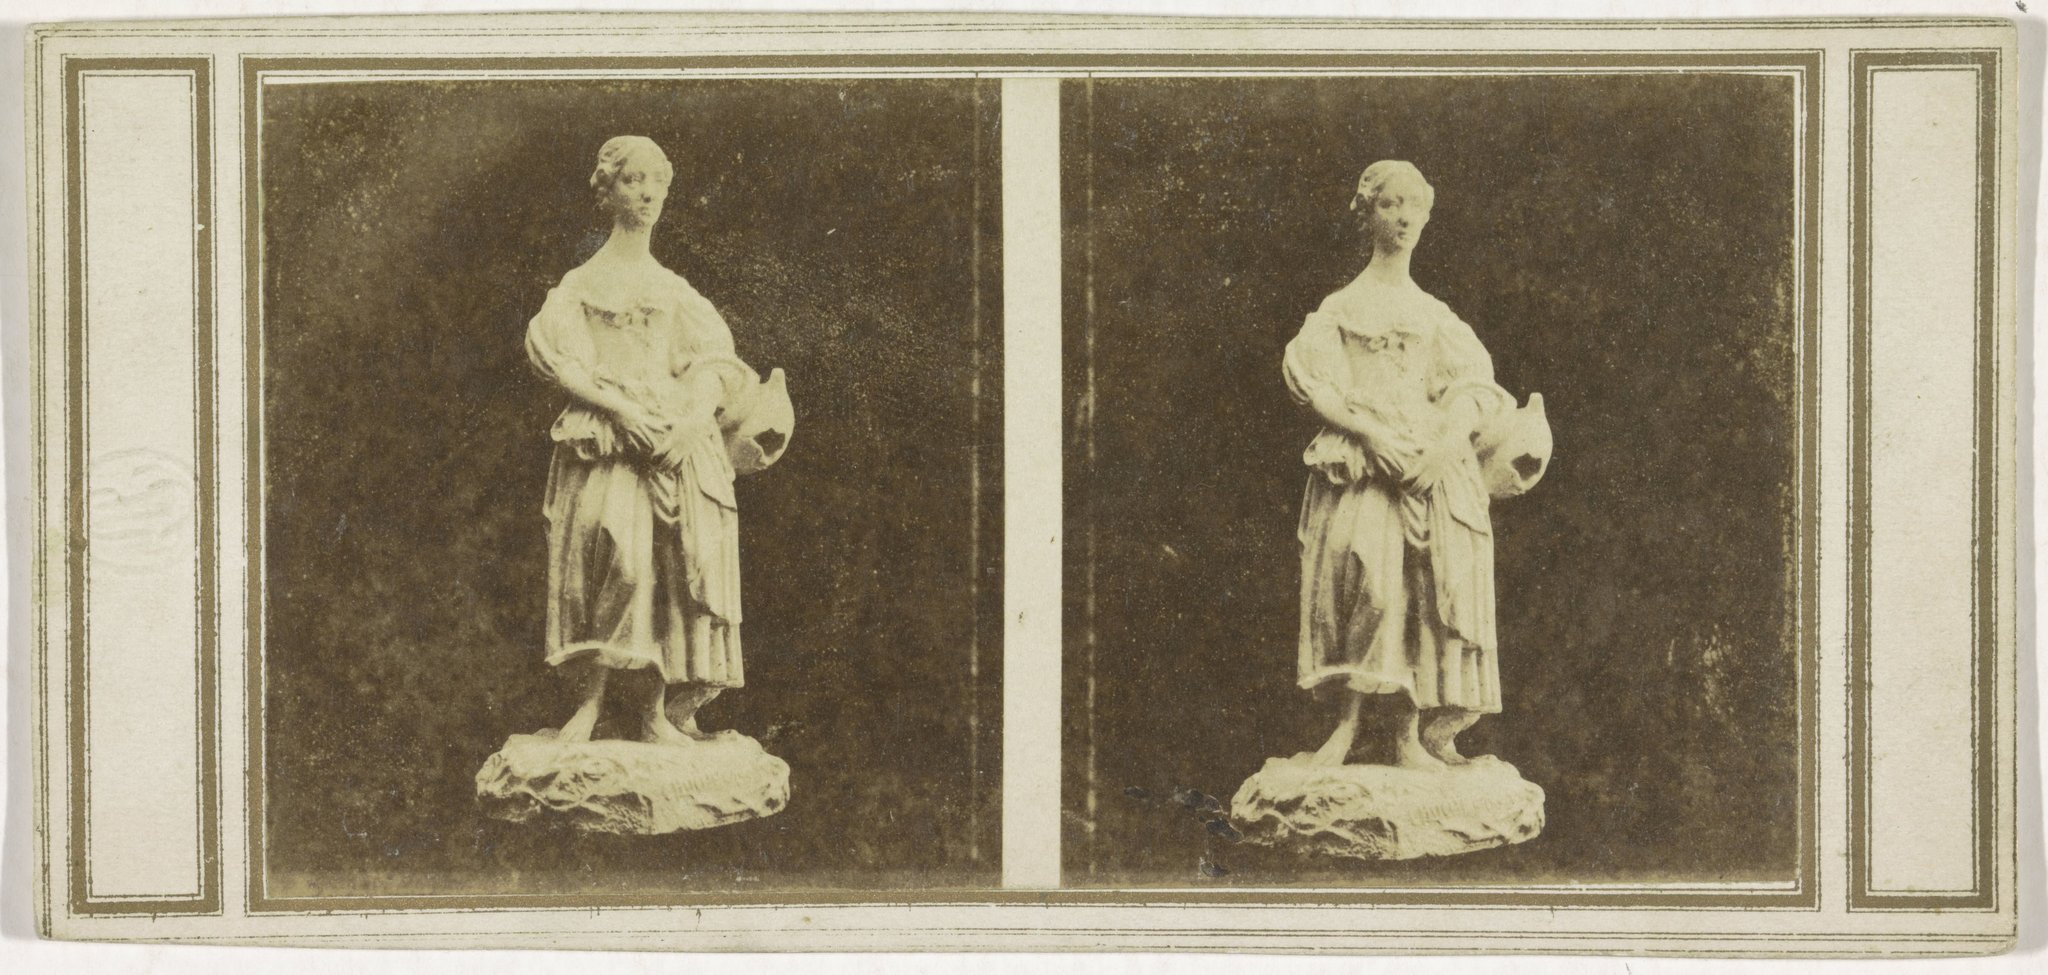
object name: stereograph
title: Beeld van de Gebroken Kruik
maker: pierre-ambroise richebourg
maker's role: fotograaf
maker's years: 1810-1875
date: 1850-1870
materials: photographic support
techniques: albumen print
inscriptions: number: ‘127’, check stamp: ‘monogram LM (?)’, title: ‘La Cruche Cassée’